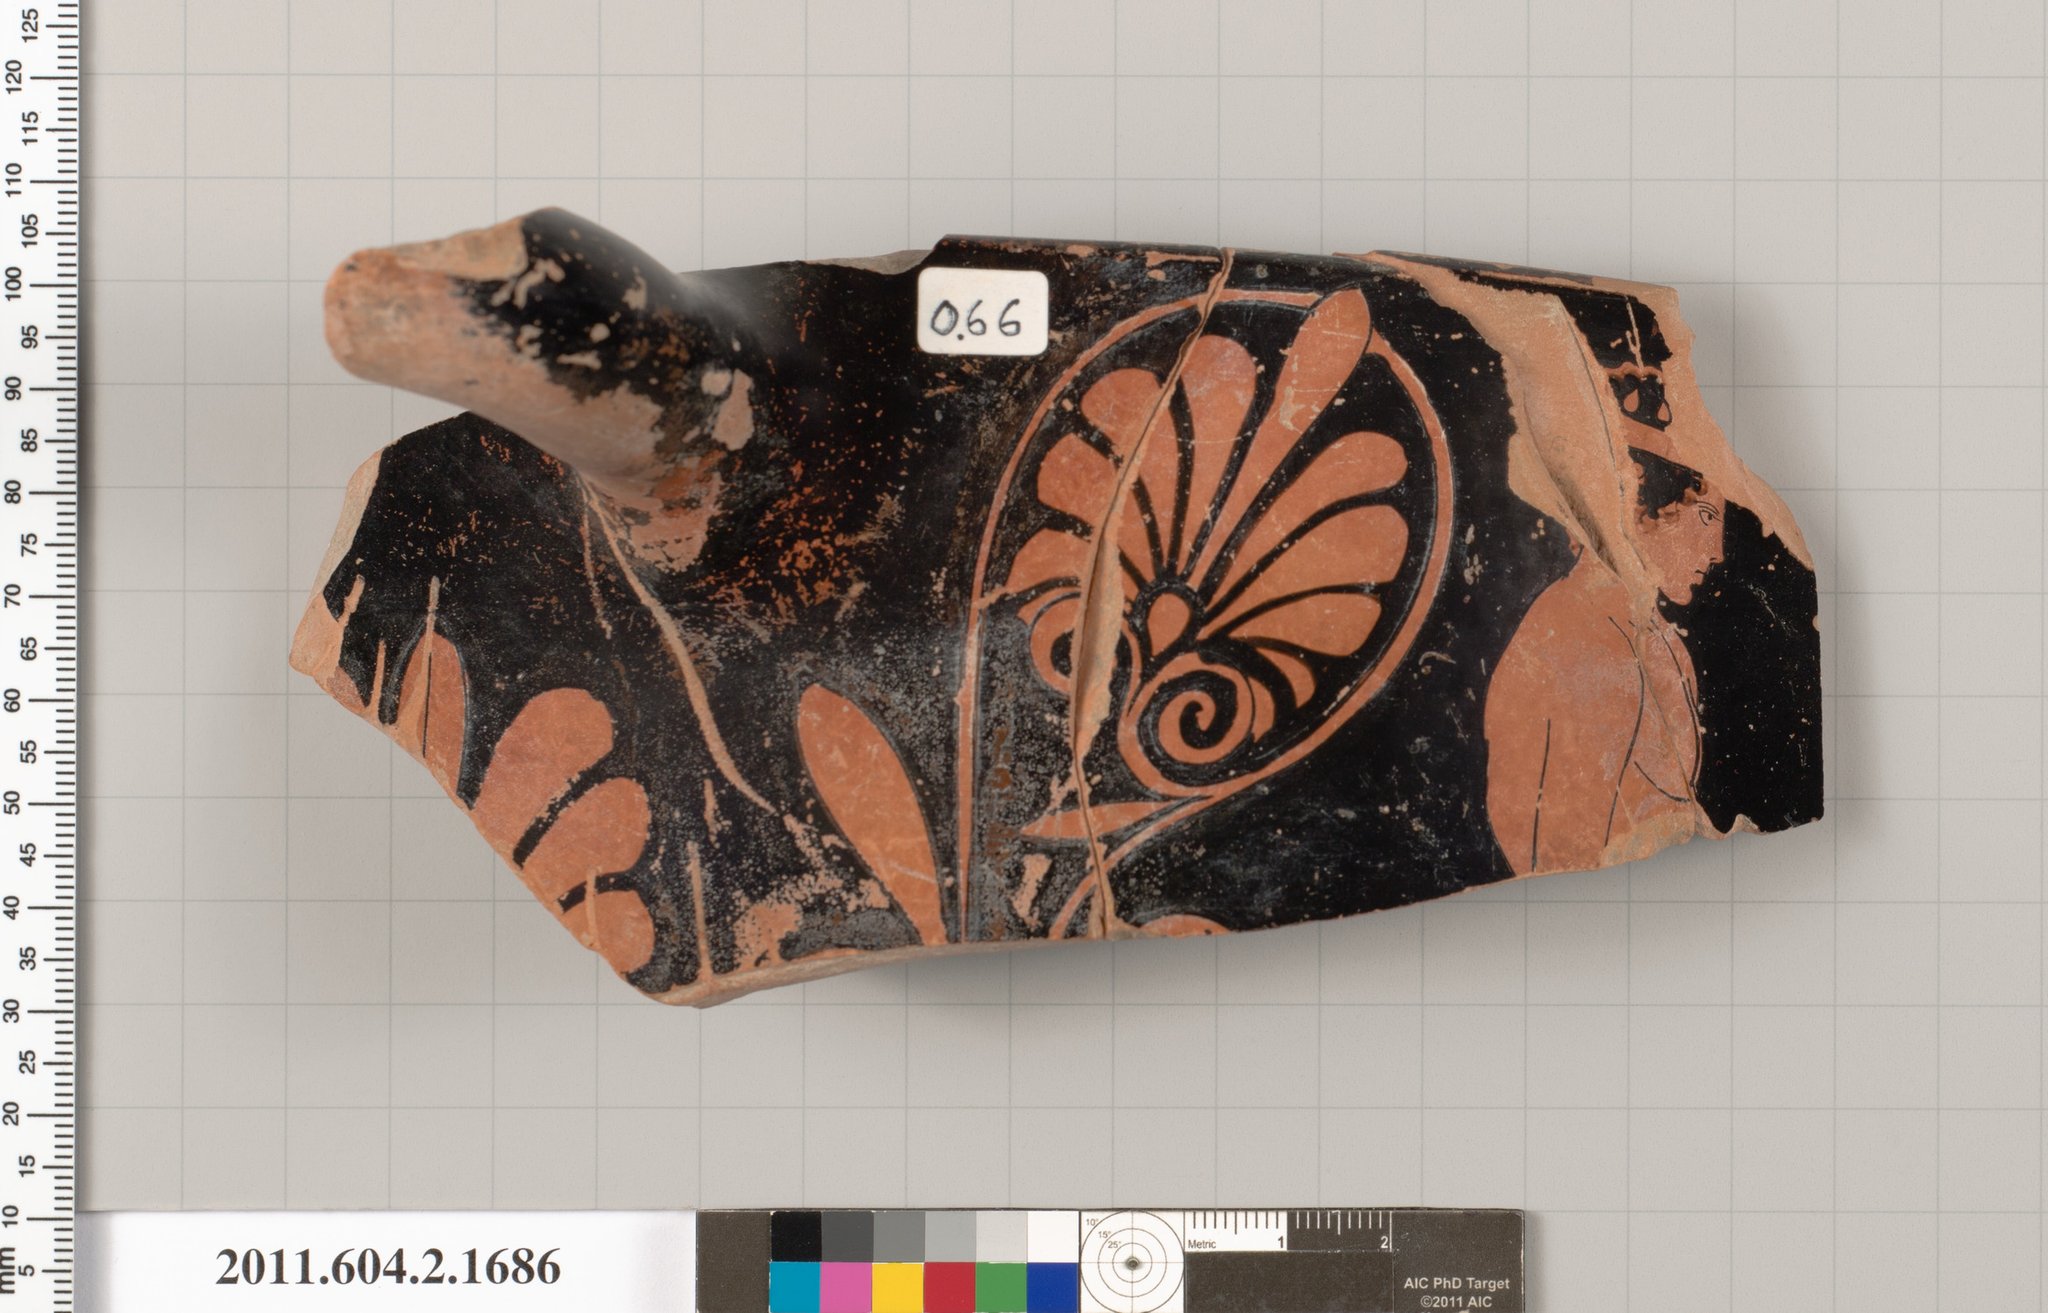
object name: skyphos fragment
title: Terracotta fragment of a skyphos (deep drinking cup)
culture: greek, attic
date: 460-450 BCE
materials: terracotta